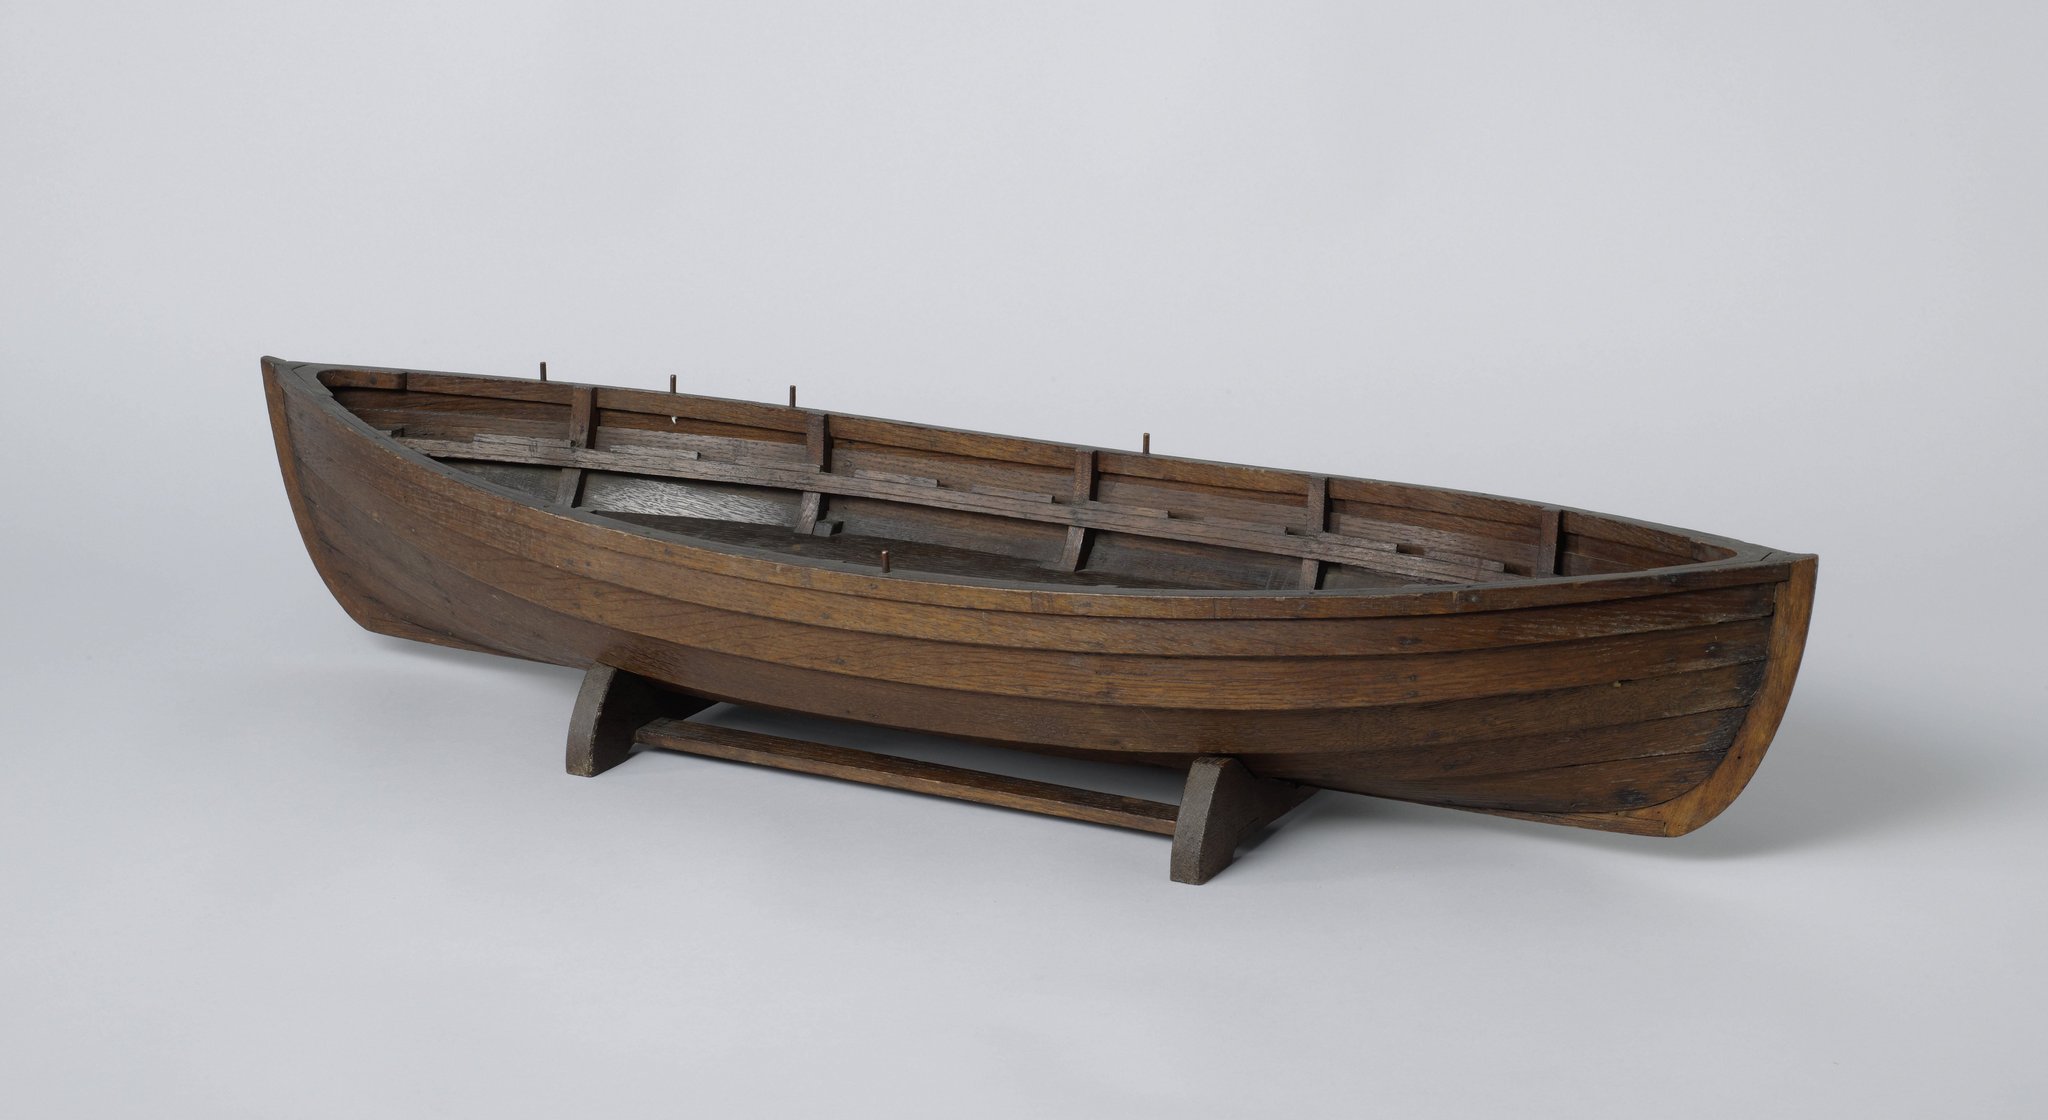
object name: ship model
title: Model of a Whaleboat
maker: Anonymous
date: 1750-1850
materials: wood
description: Model van een overnaadse twaalfriems dubbelbanks walvissloep op standaard. Het vaartuig is een spitsgatter met verhoogde vloer, waarvan de middendelen ontbreken. Ook alle doften ontbreken. Op het boord twaalf dollen en nog eens vier aan een kant. De middelste vloerbalk heeft een oog.